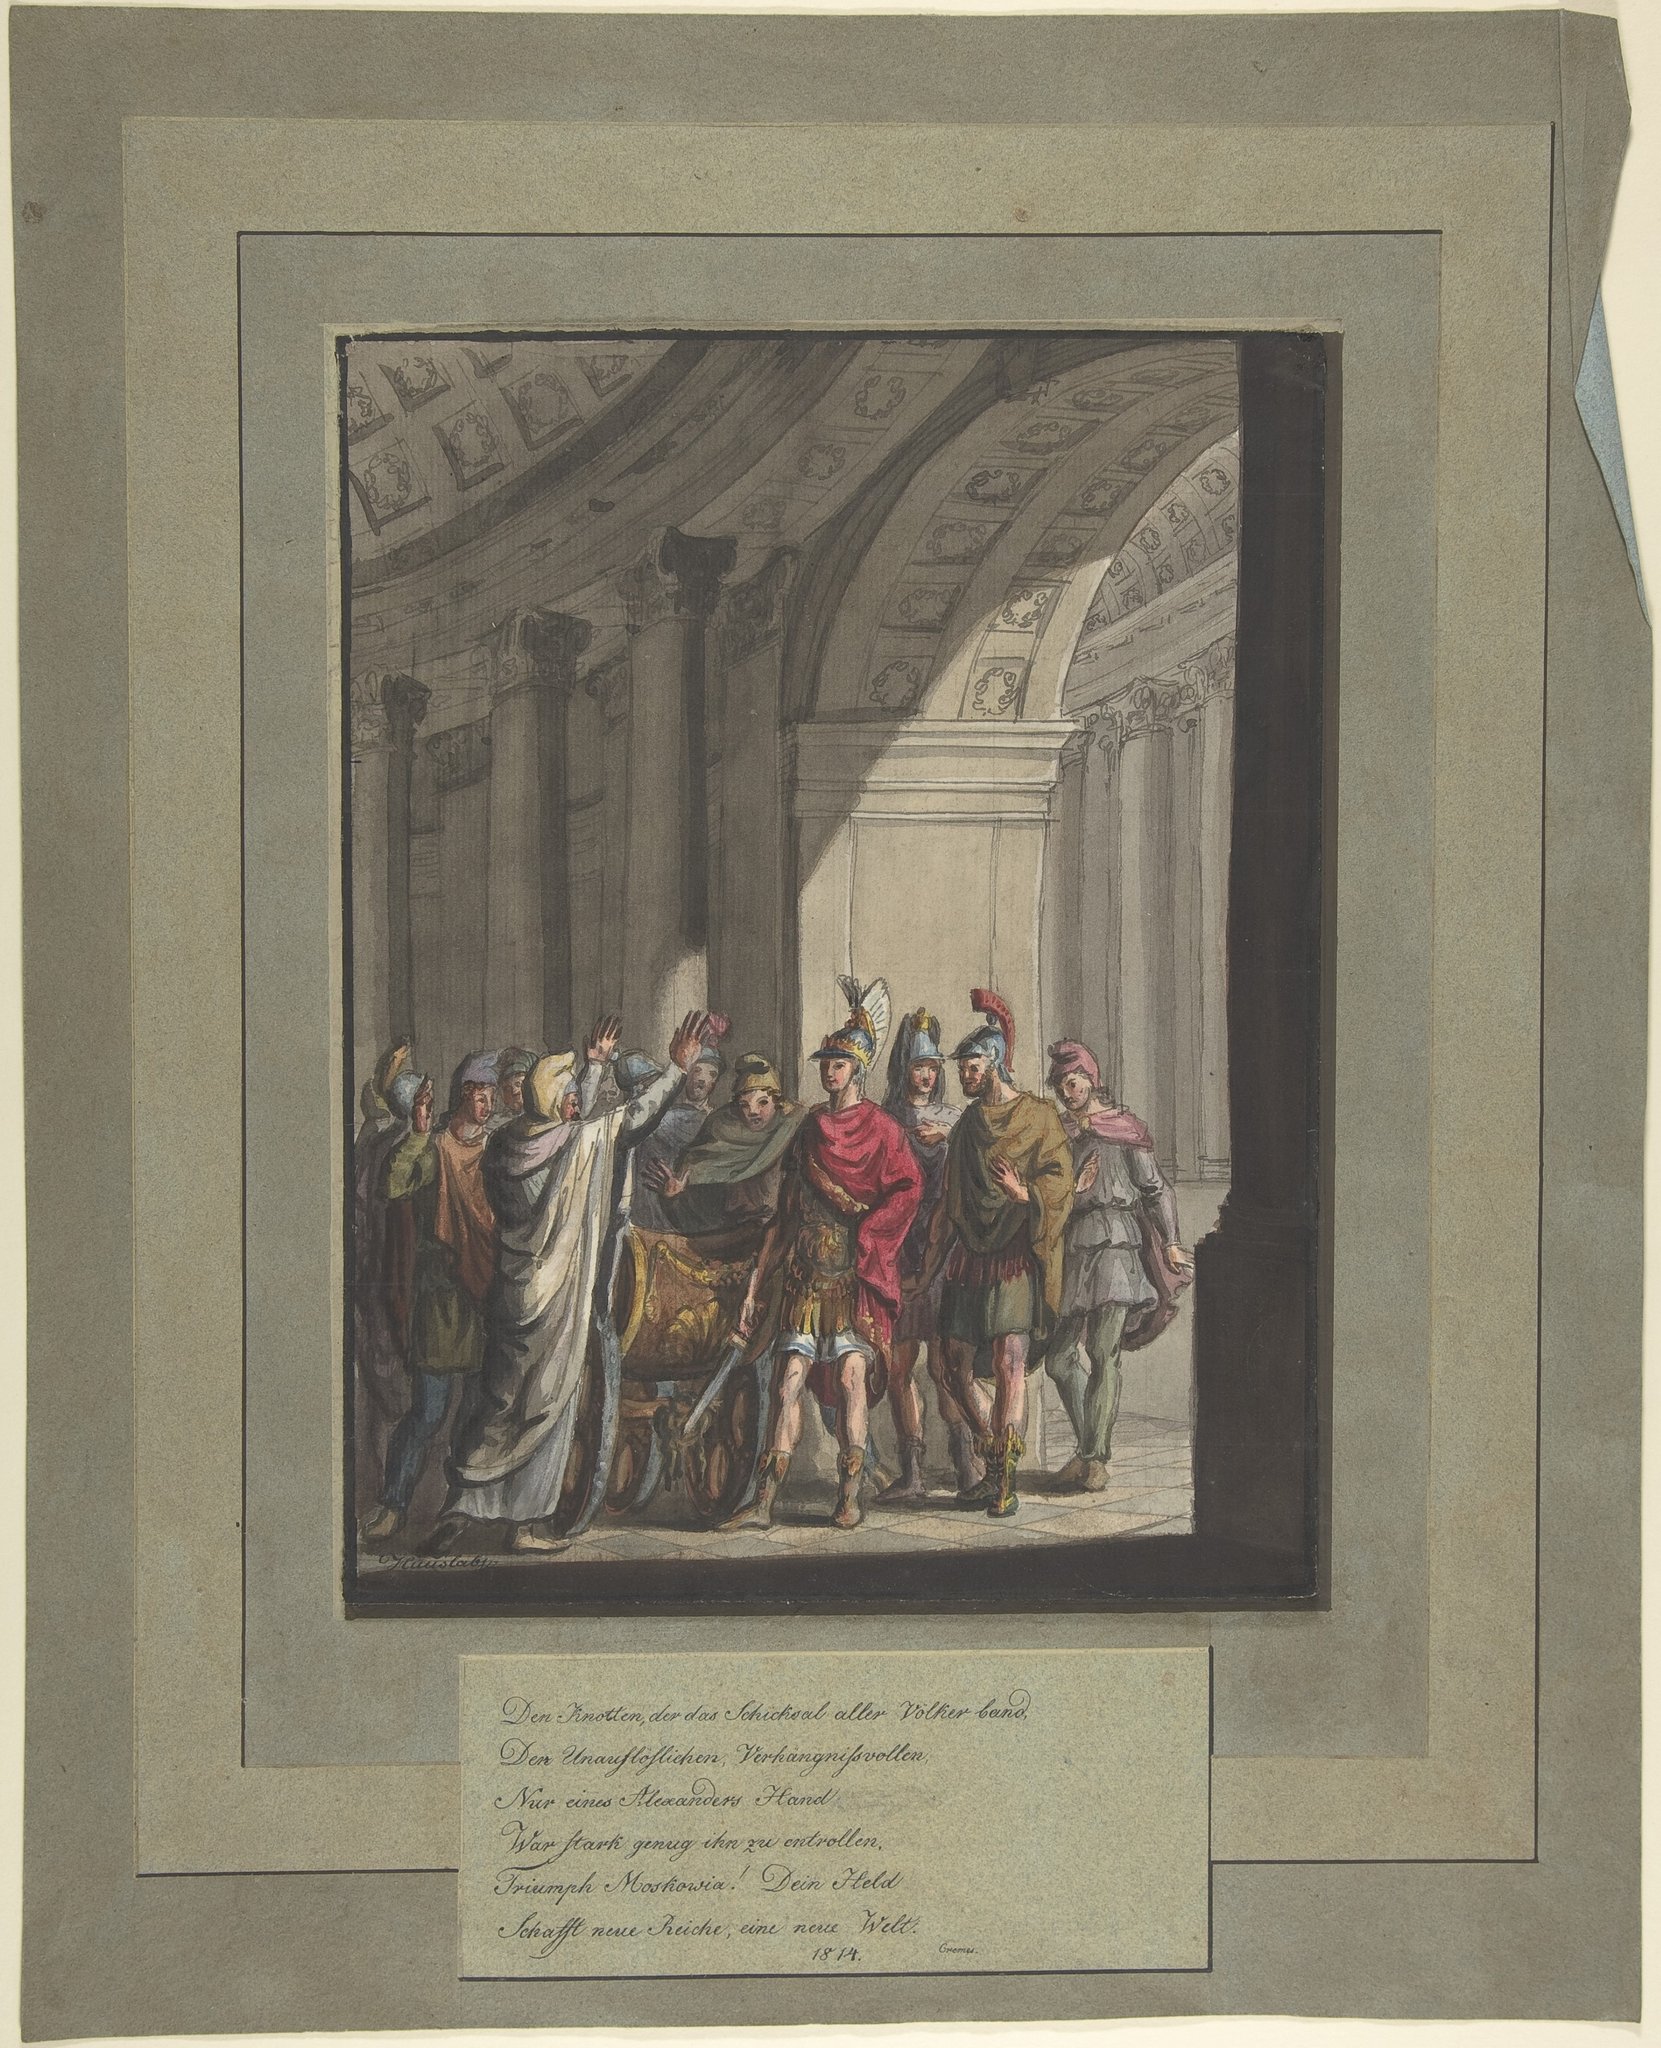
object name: drawing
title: Allegory of Victory of Russians over Napoleon's Army, from a poem by Cremes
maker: franz von hauslab the younger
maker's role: artist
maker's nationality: austrian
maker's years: 1798-1883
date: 1814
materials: gouache, ink, watercolor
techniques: pen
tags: army,men